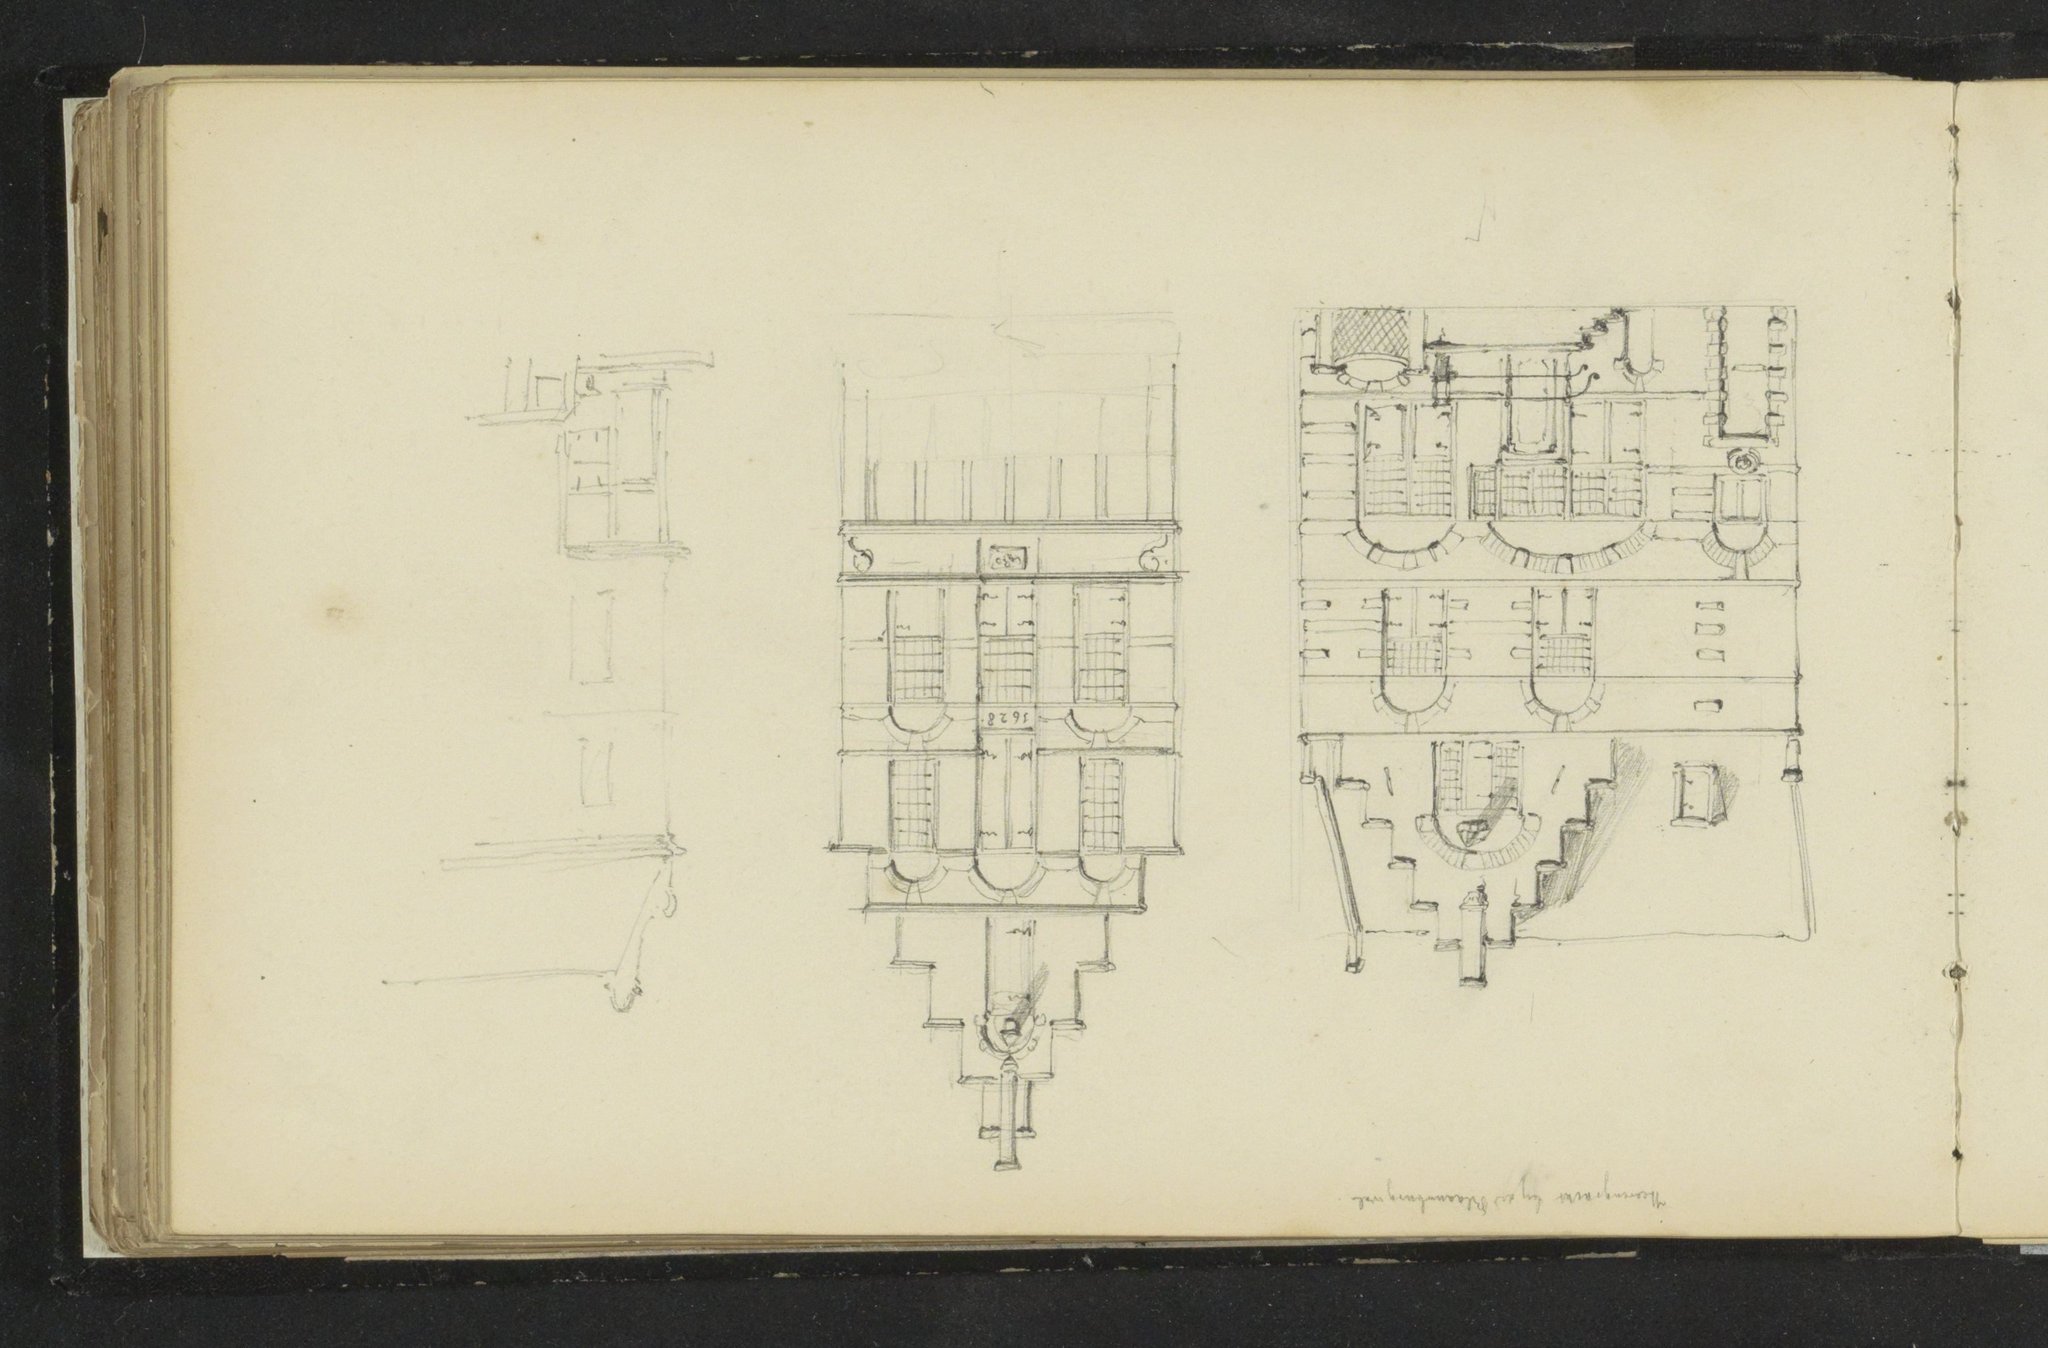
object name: sketchbook leaf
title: Drie gevels aan de Herengracht te Amsterdam, ter hoogte van de Blauwburgwal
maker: cornelis springer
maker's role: draughtsman, painter, print maker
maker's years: 1817-1891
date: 1846-1882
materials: paper, pencil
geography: amsterdam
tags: façade (of house or building)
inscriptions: annotation: ‘Heerengracht by de Blaauwburgwal’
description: Drie gevels aan de Herengracht te Amsterdam, ter hoogte van de Blauwburgwal. Blad 73 verso uit een schetsboek met 91 bladen.